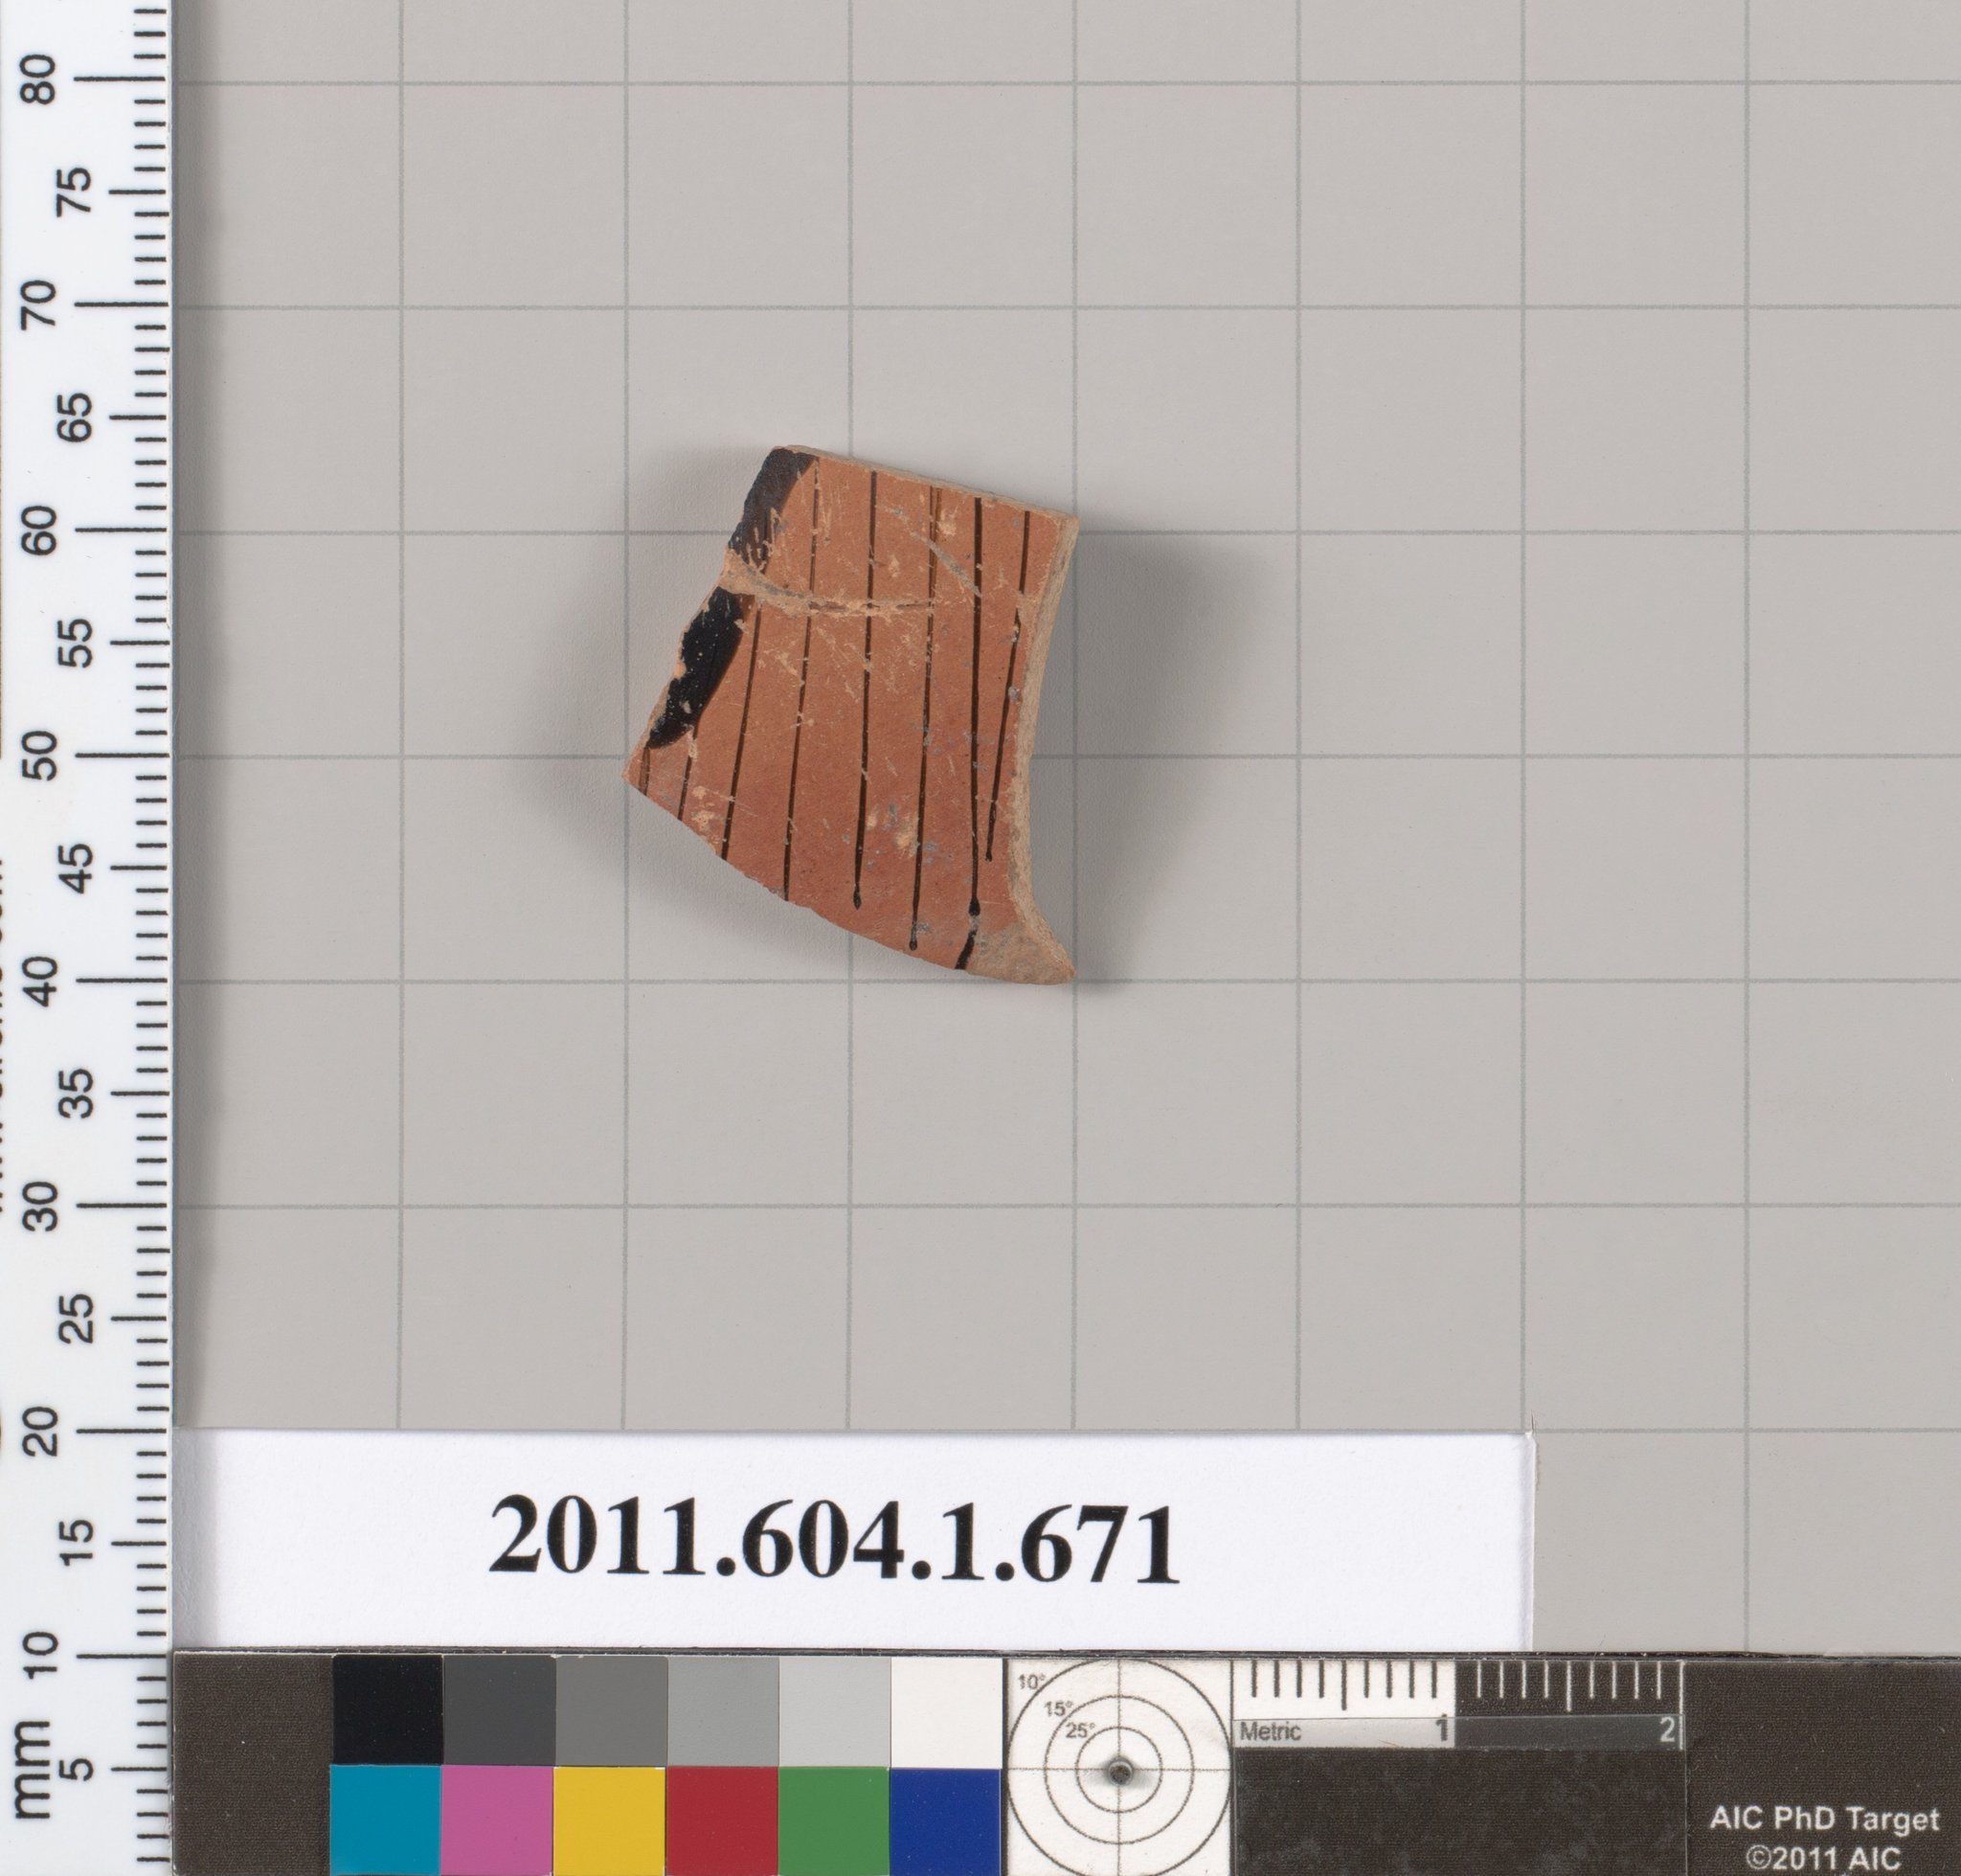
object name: kylix fragment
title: Terracotta fragment of a kylix (drinking cup)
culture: greek, attic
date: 475-451 BCE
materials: terracotta